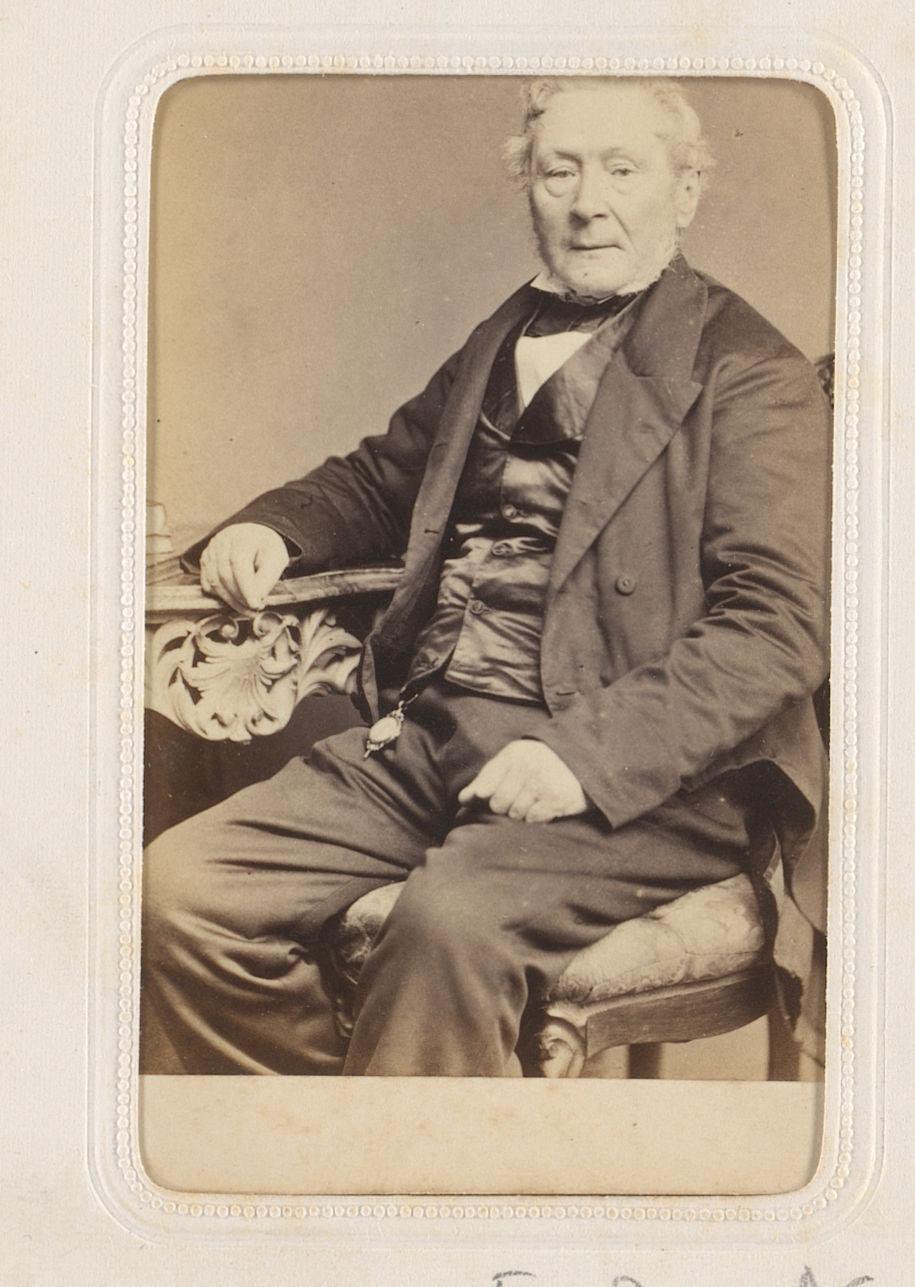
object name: photograph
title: Portret van een zittende man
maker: peter carstensen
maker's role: fotograaf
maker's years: 1817-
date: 1860-1868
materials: cardboard, photographic support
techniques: albumen print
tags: sitting figure, adult man, historical persons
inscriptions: inscription: ‘Photographisch Atelier/ P. Carstensen/ Nieuwendyk H. 201/ Amsterdam’